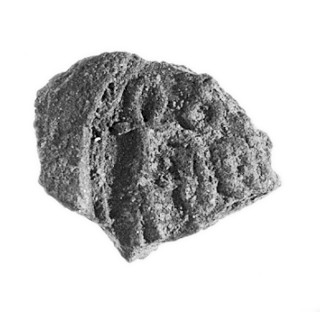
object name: sealing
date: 1981-1640 BCE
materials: mud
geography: egypt